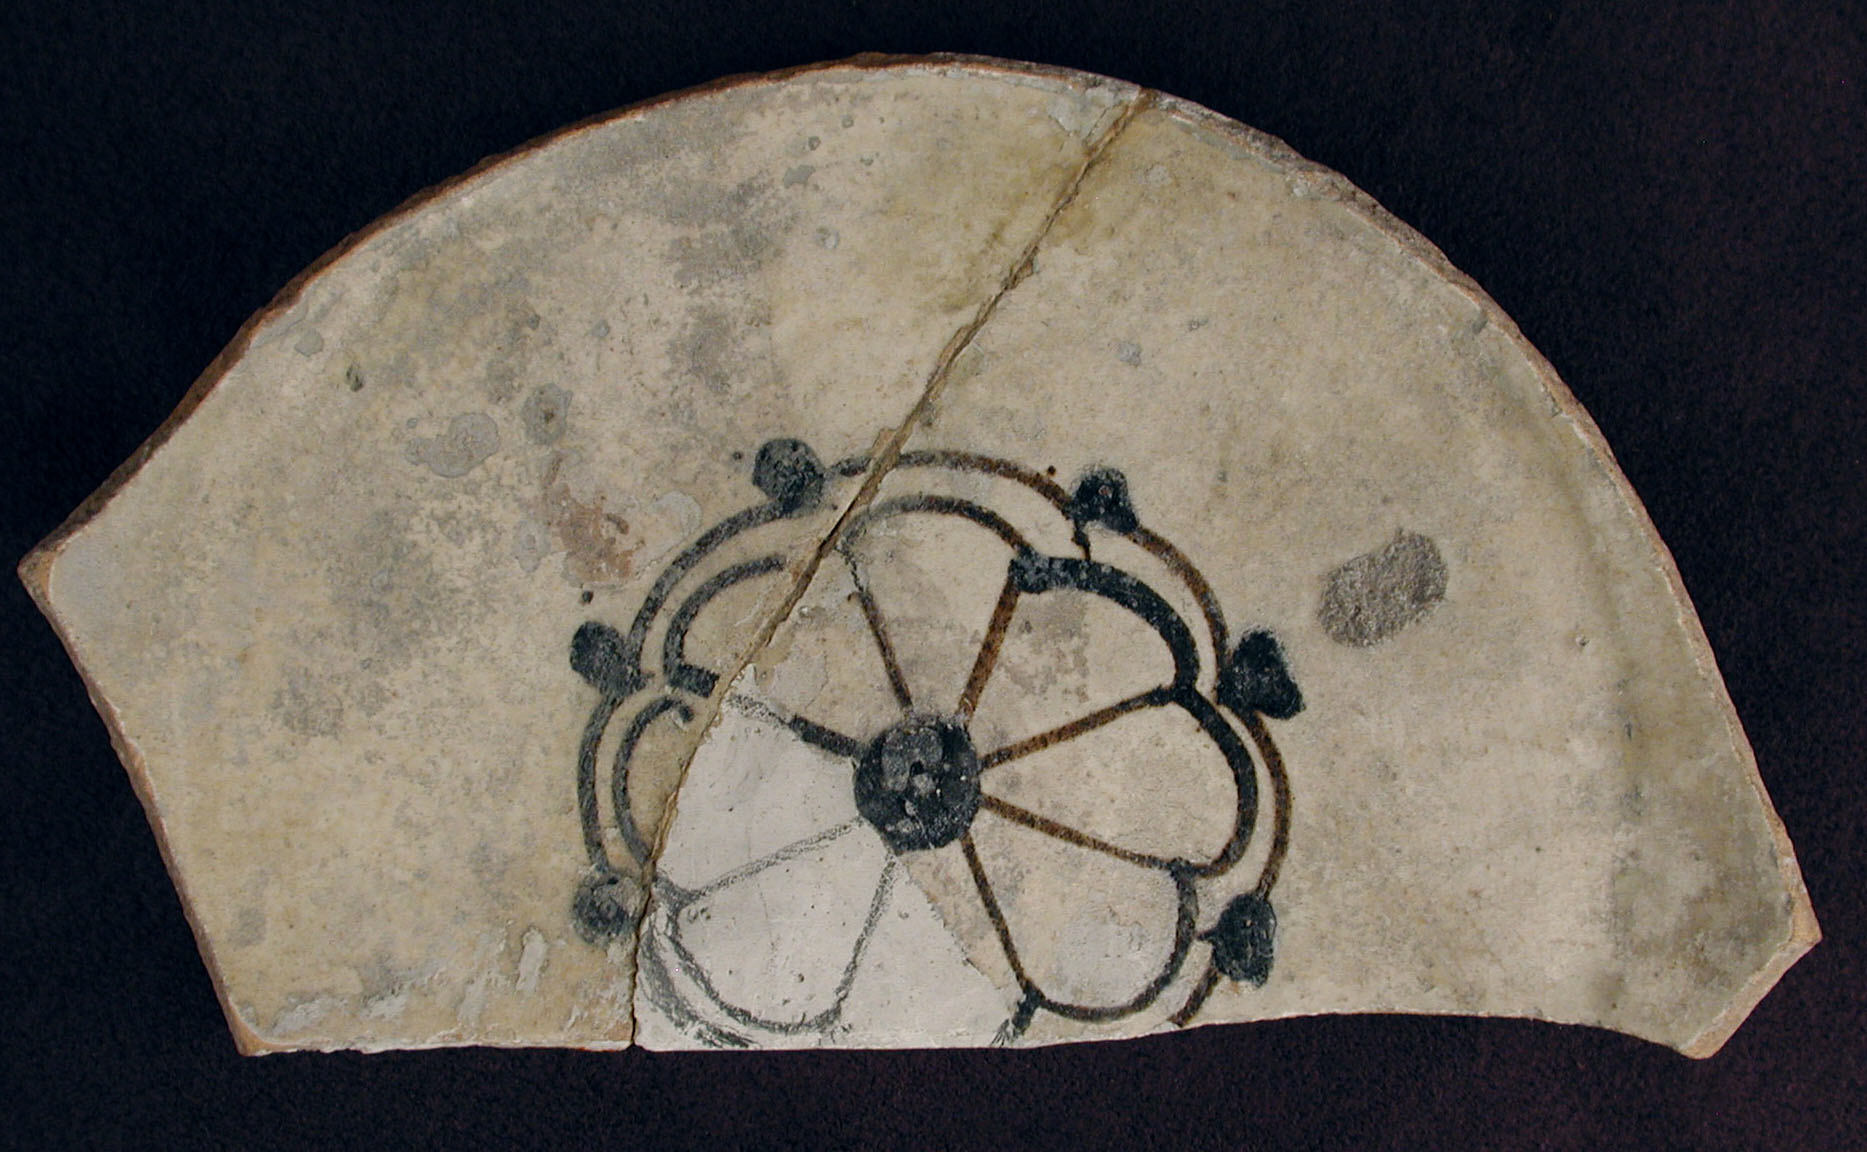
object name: fragment of a bowl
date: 901-1000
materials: earthenware, glaze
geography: iran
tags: flowers